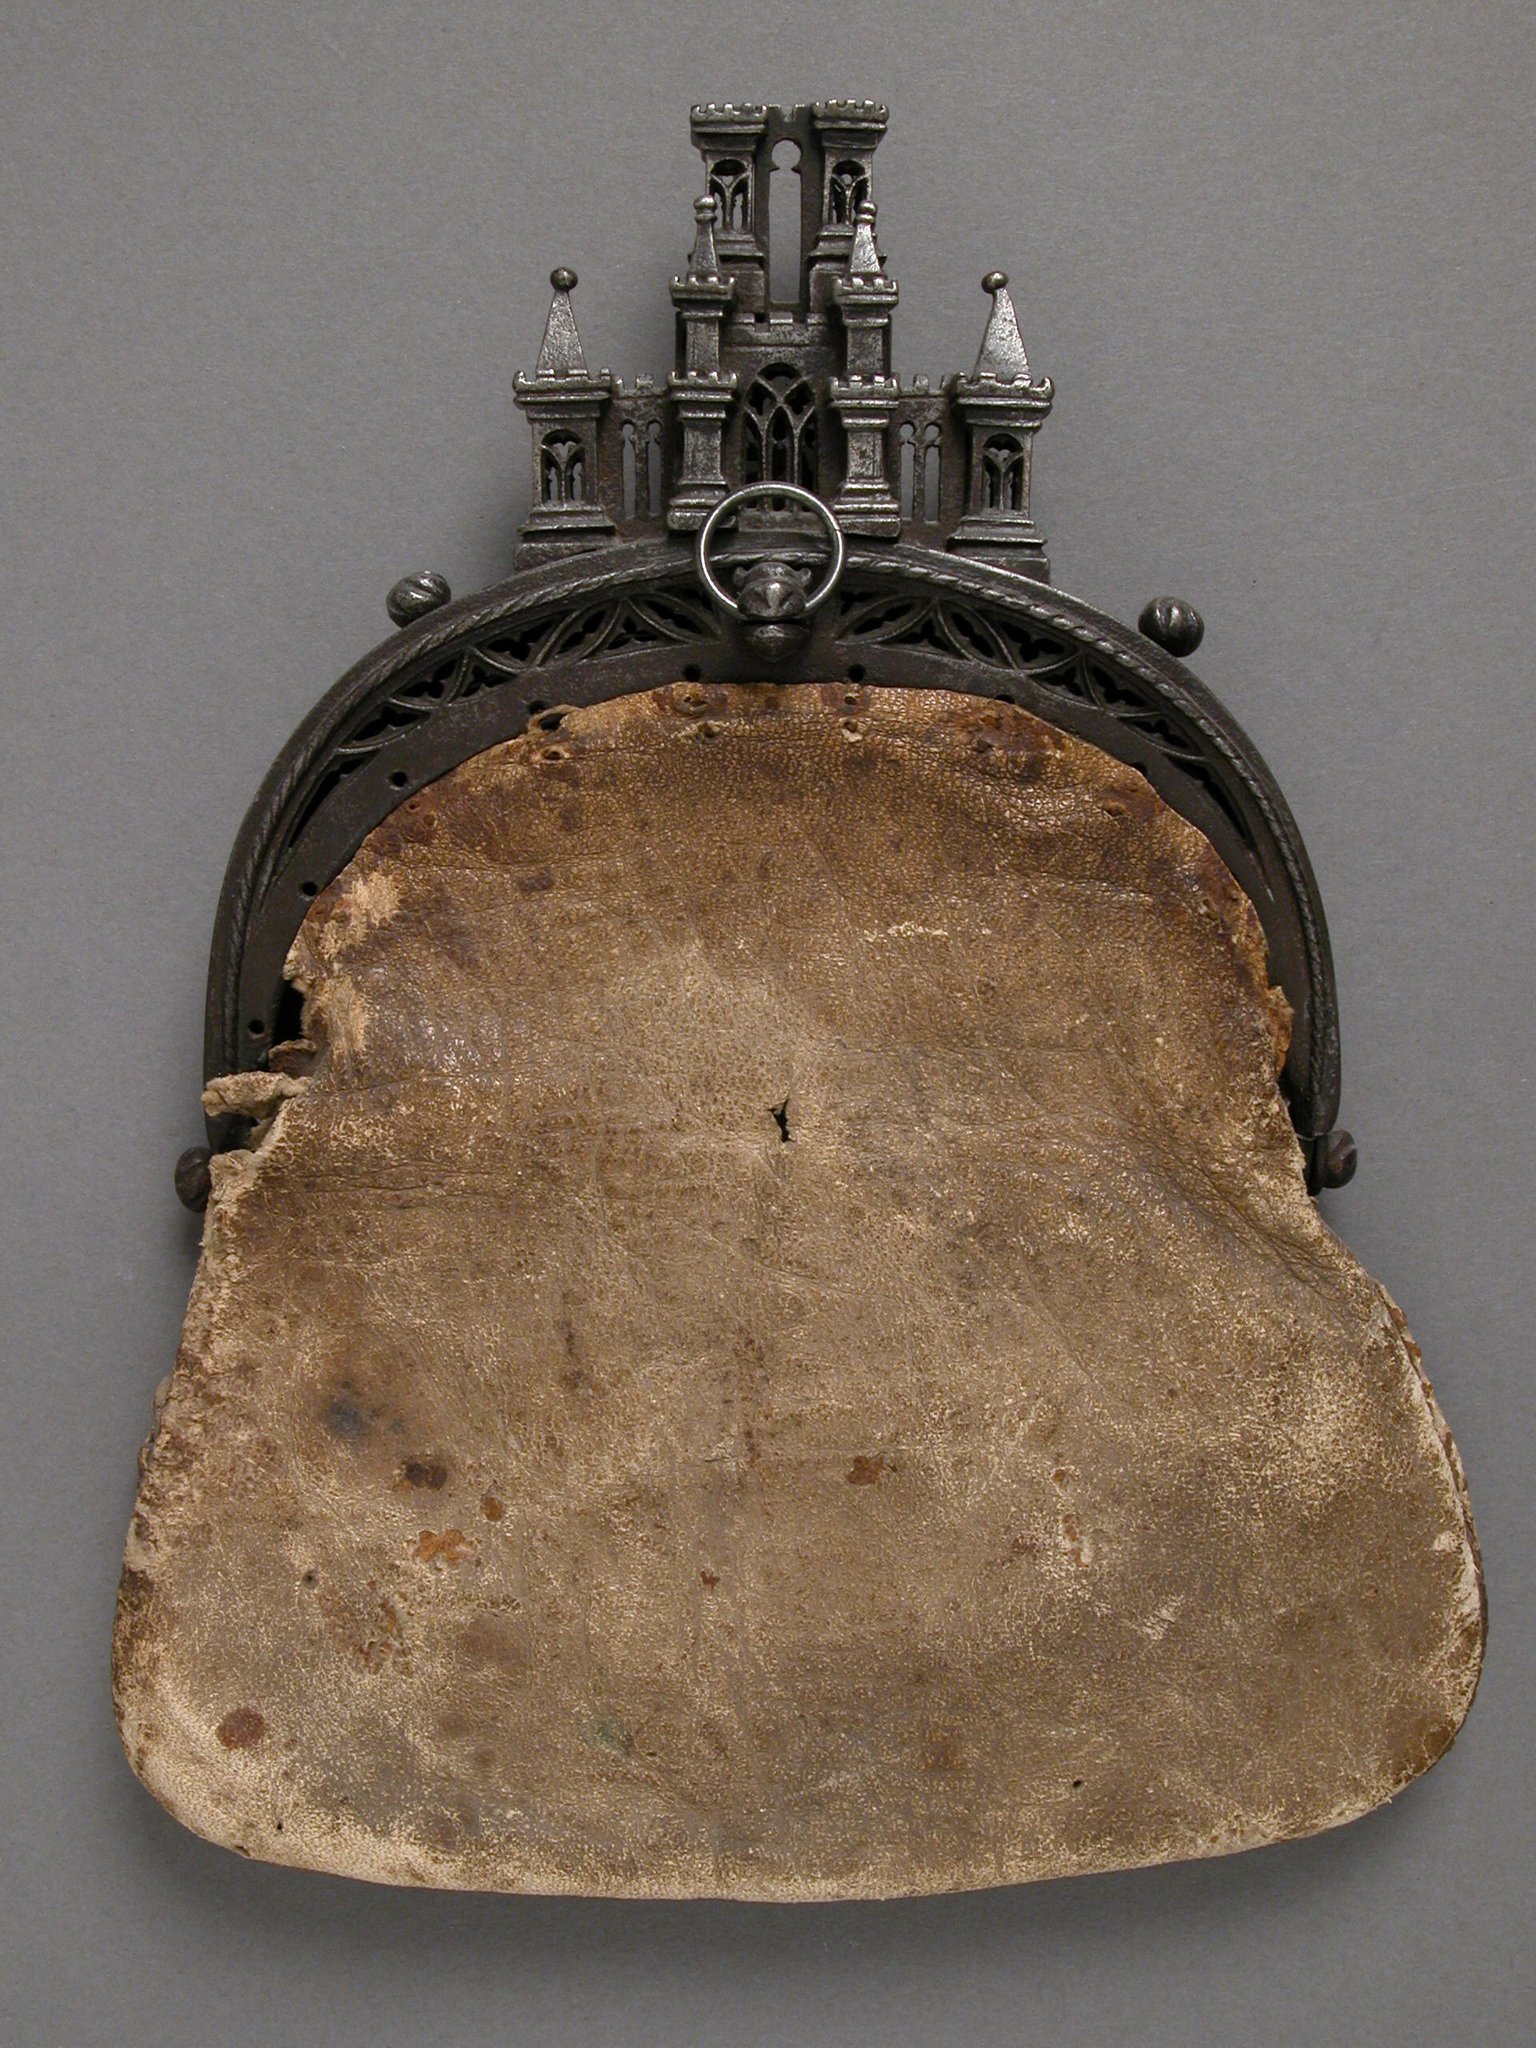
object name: purse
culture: european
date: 1401-1600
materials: iron, leather